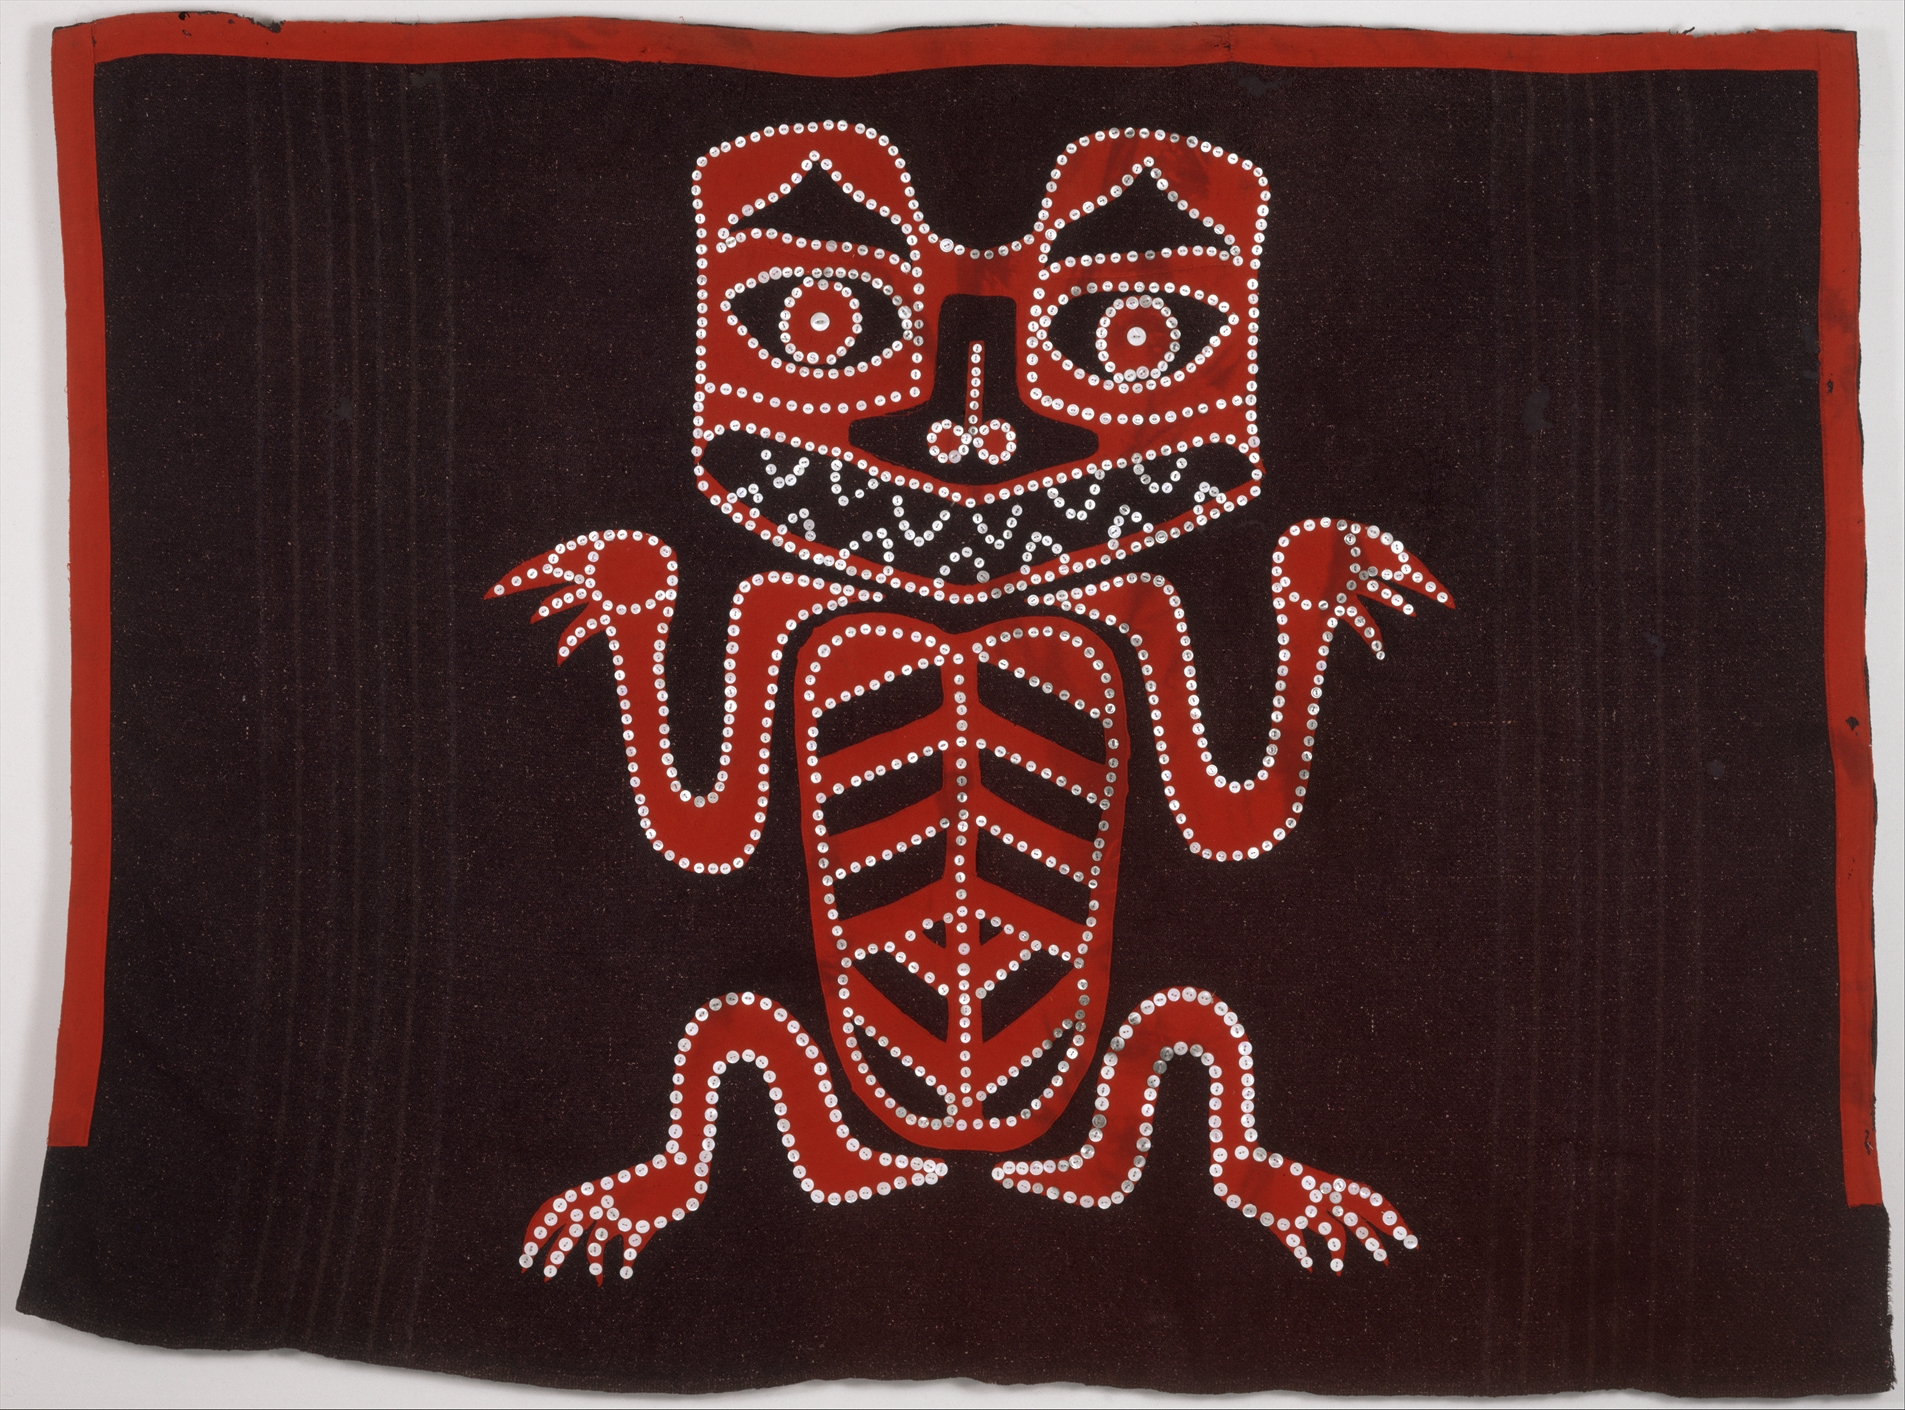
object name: button blanket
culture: kagani haida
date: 1880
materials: textile, shell, wool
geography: united states